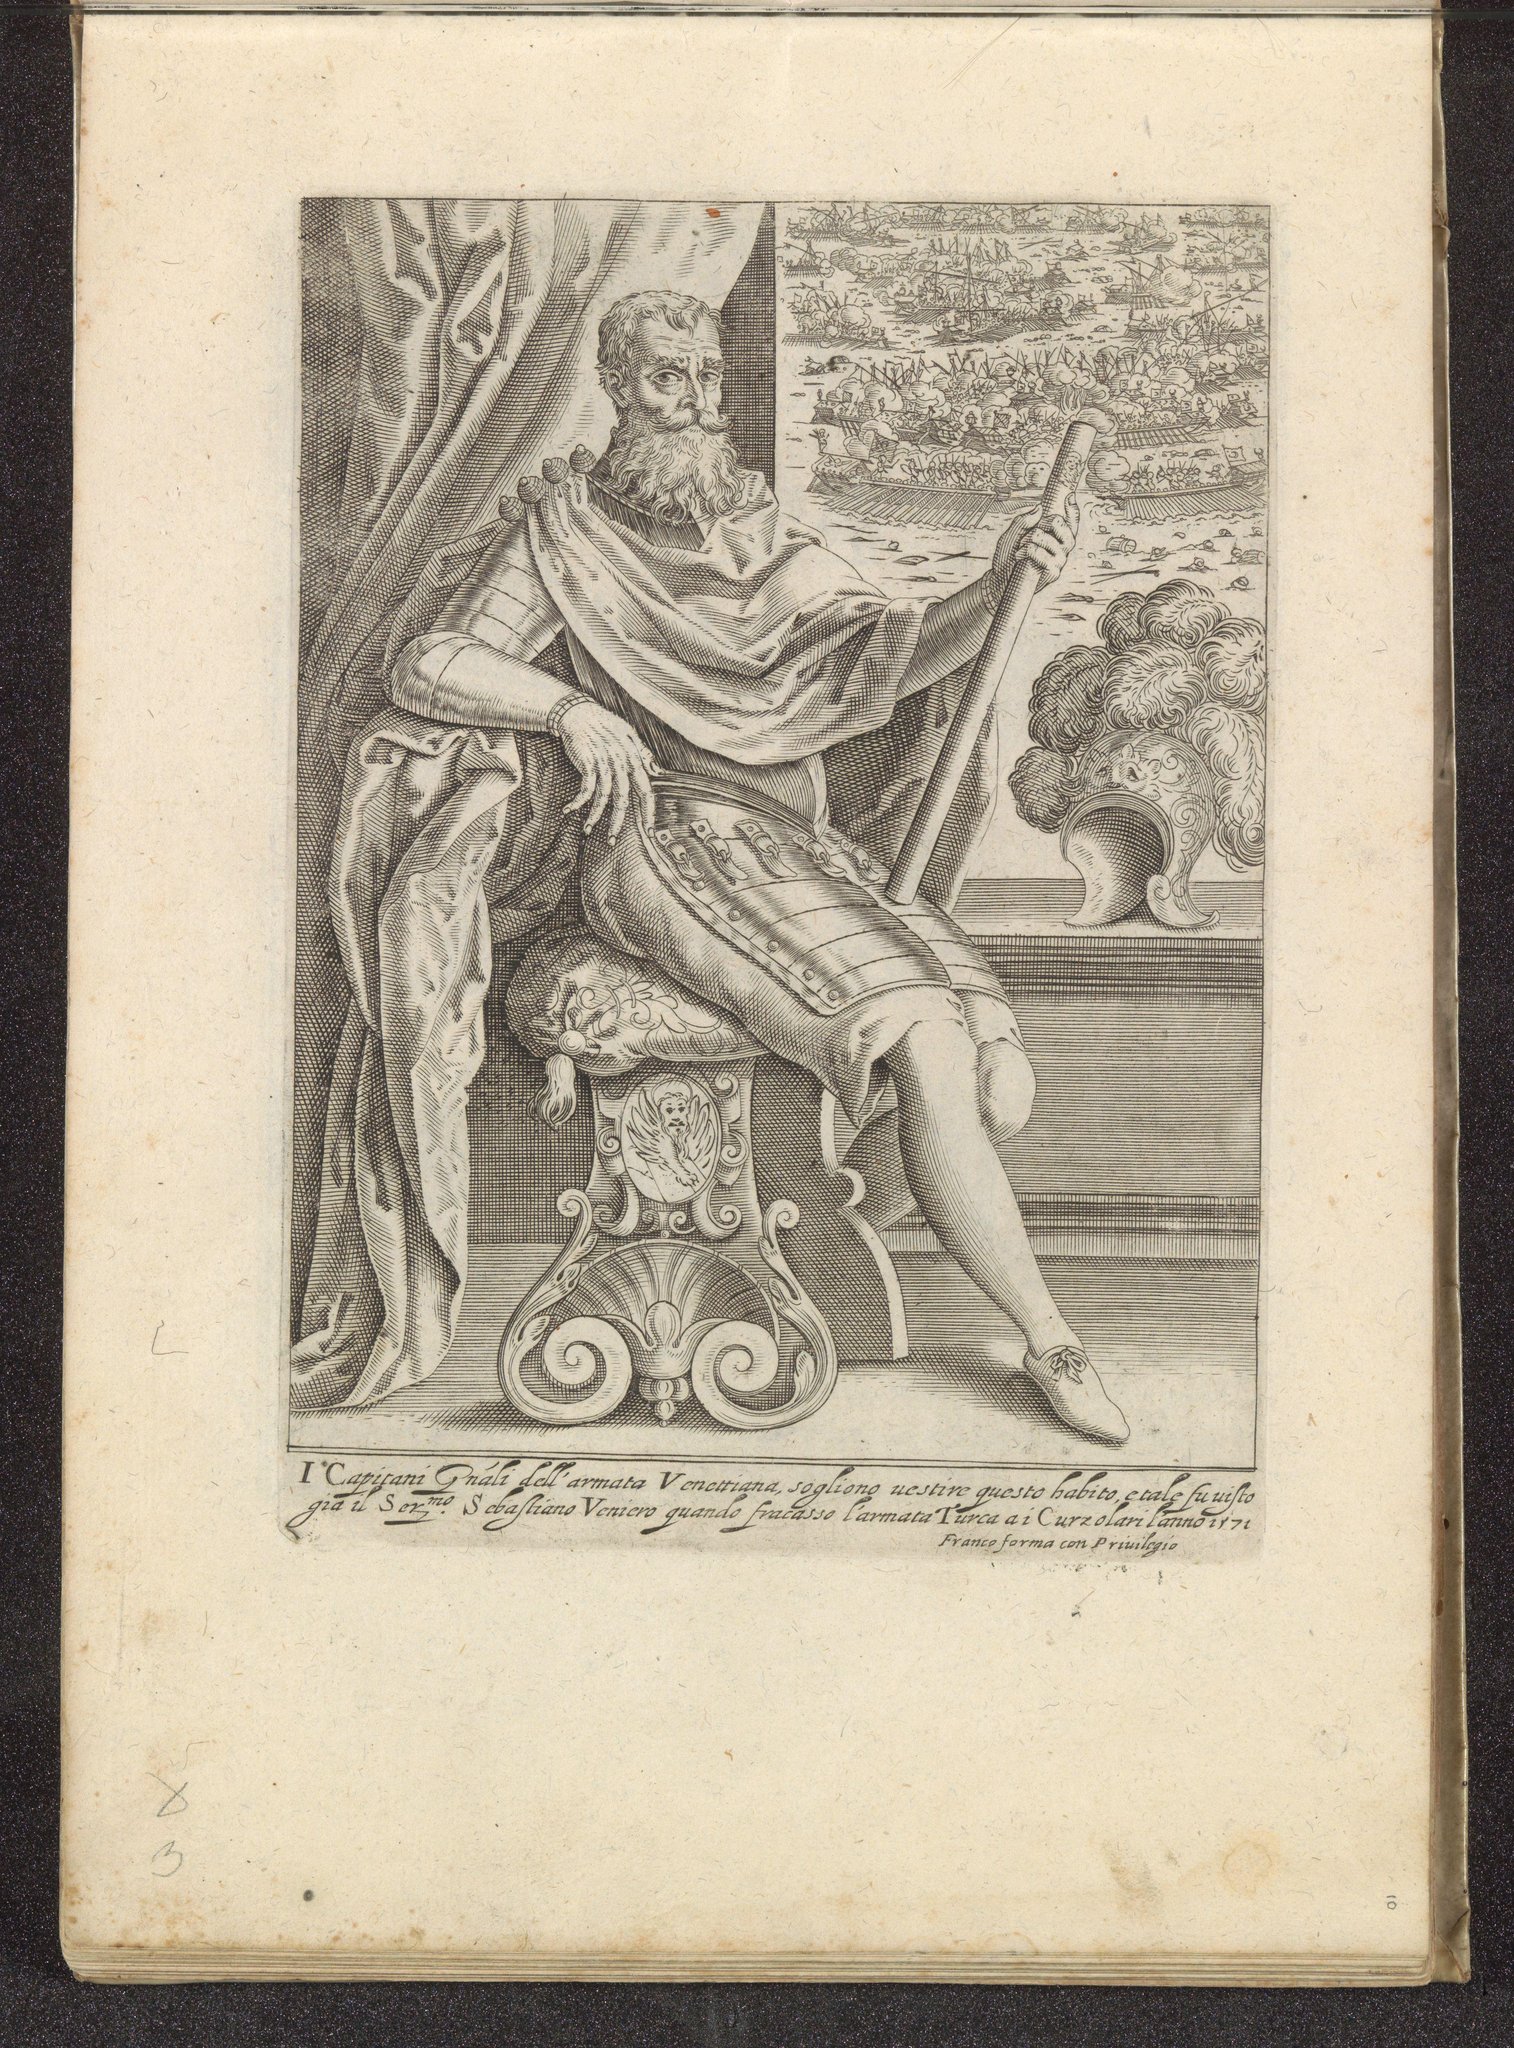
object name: print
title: Admiraal Sebastiano Vernier en de Slag bij Lepanto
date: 1610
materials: paper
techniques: engraving, intaglio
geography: italy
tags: battle (+ naval force), commander-in-chief, admiral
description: Admiraal Sebastiano Vernier zittend met rechts een doorkijk naar de Slag bij Lepanto. Tweeregelige Italiaanse tekst in ondermarge. De prent maakt deel uit van een album.